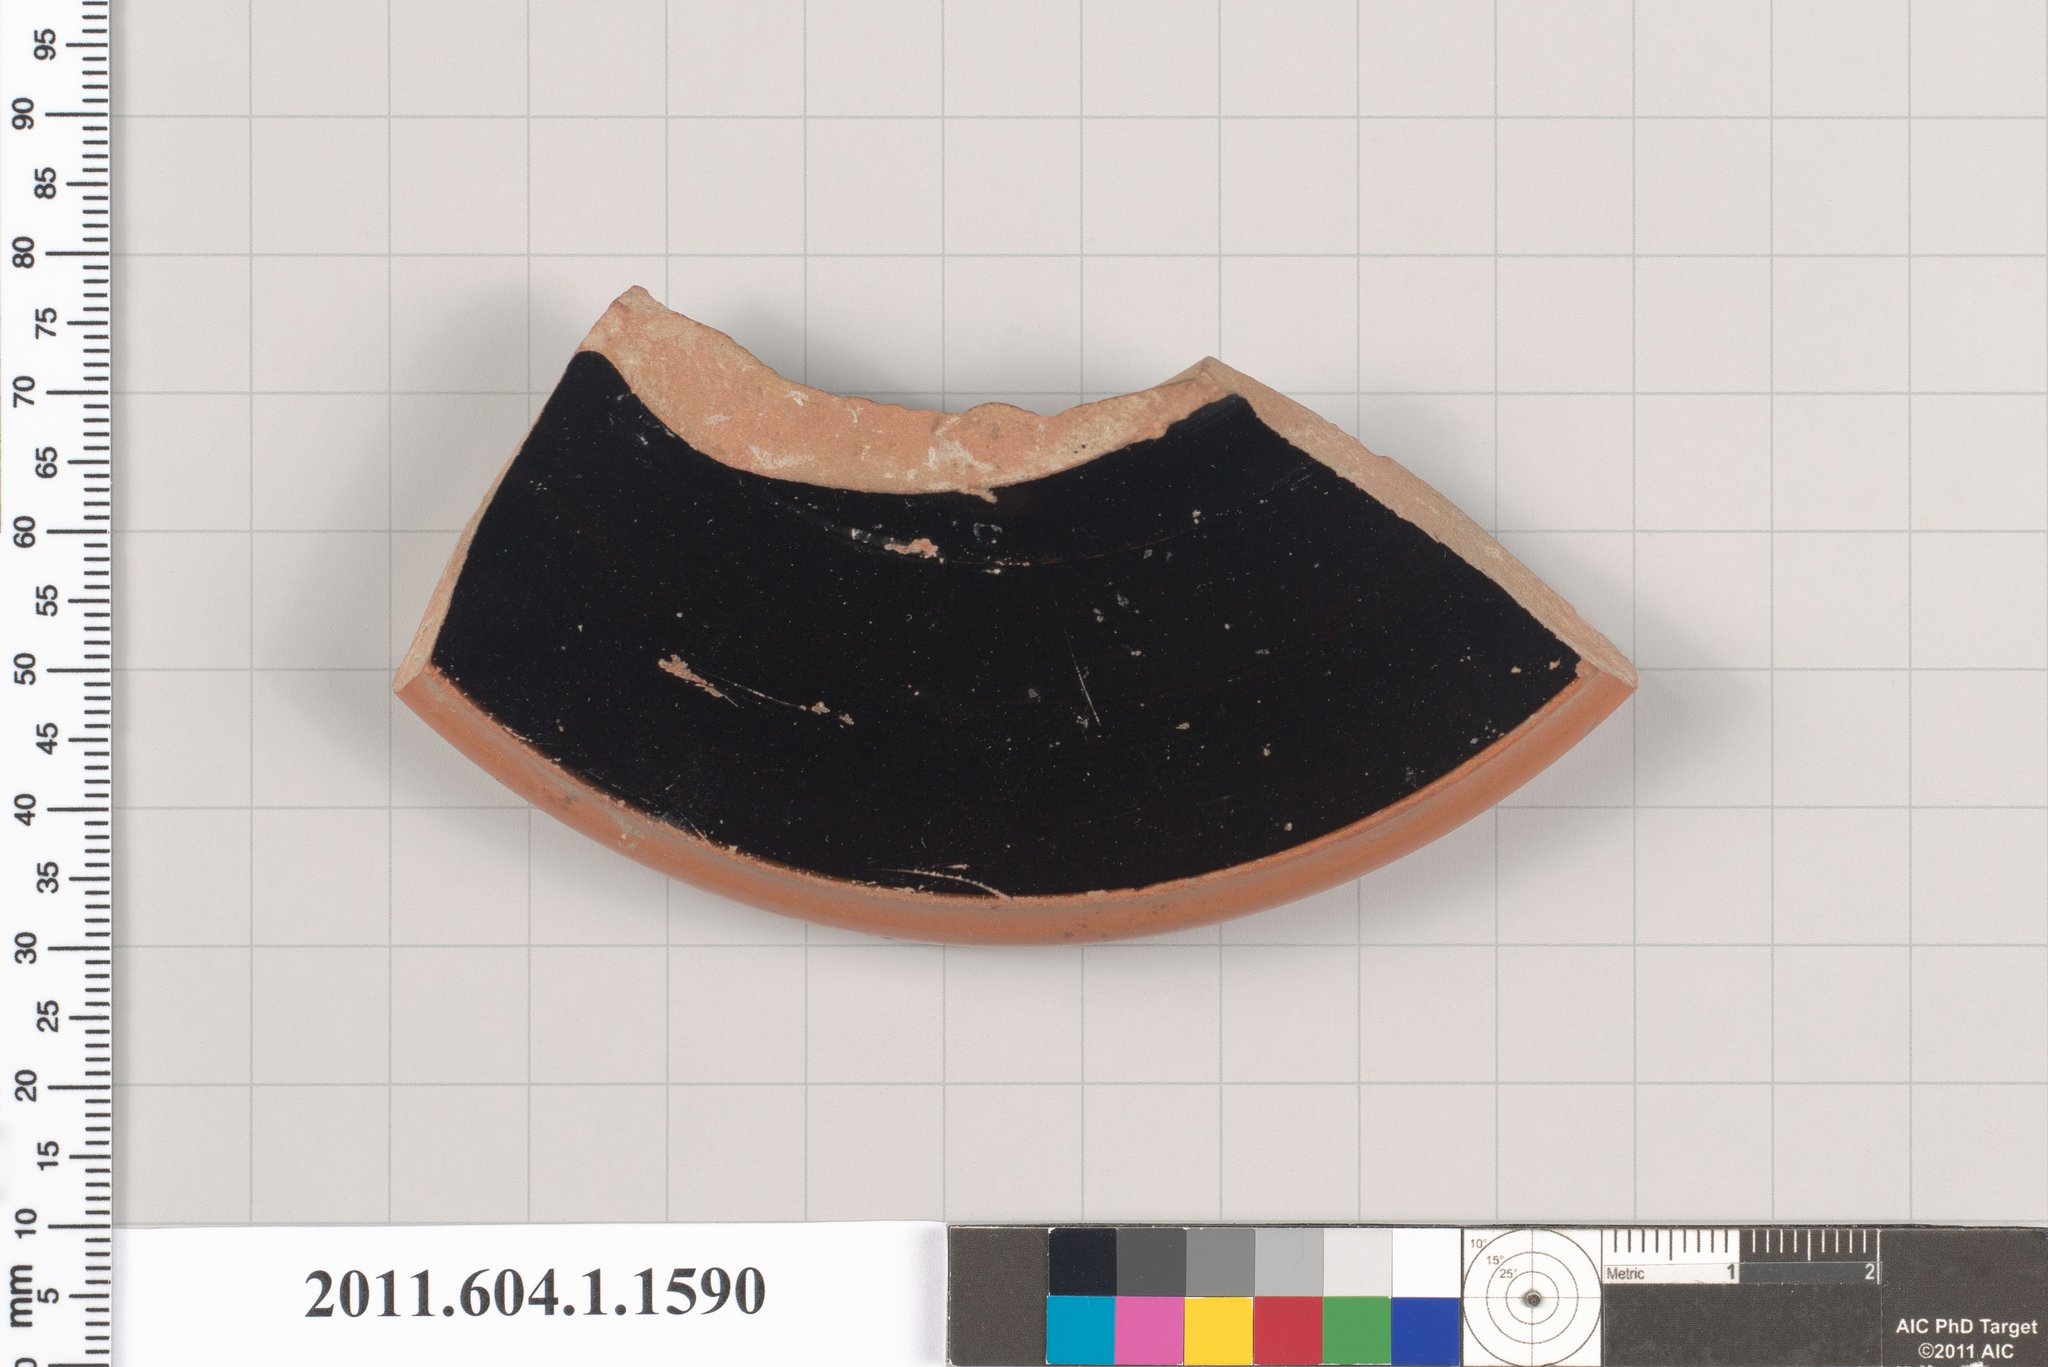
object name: kylix fragment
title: Terracotta fragment of a kylix (drinking cup)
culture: greek, attic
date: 500-401 BCE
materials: terracotta